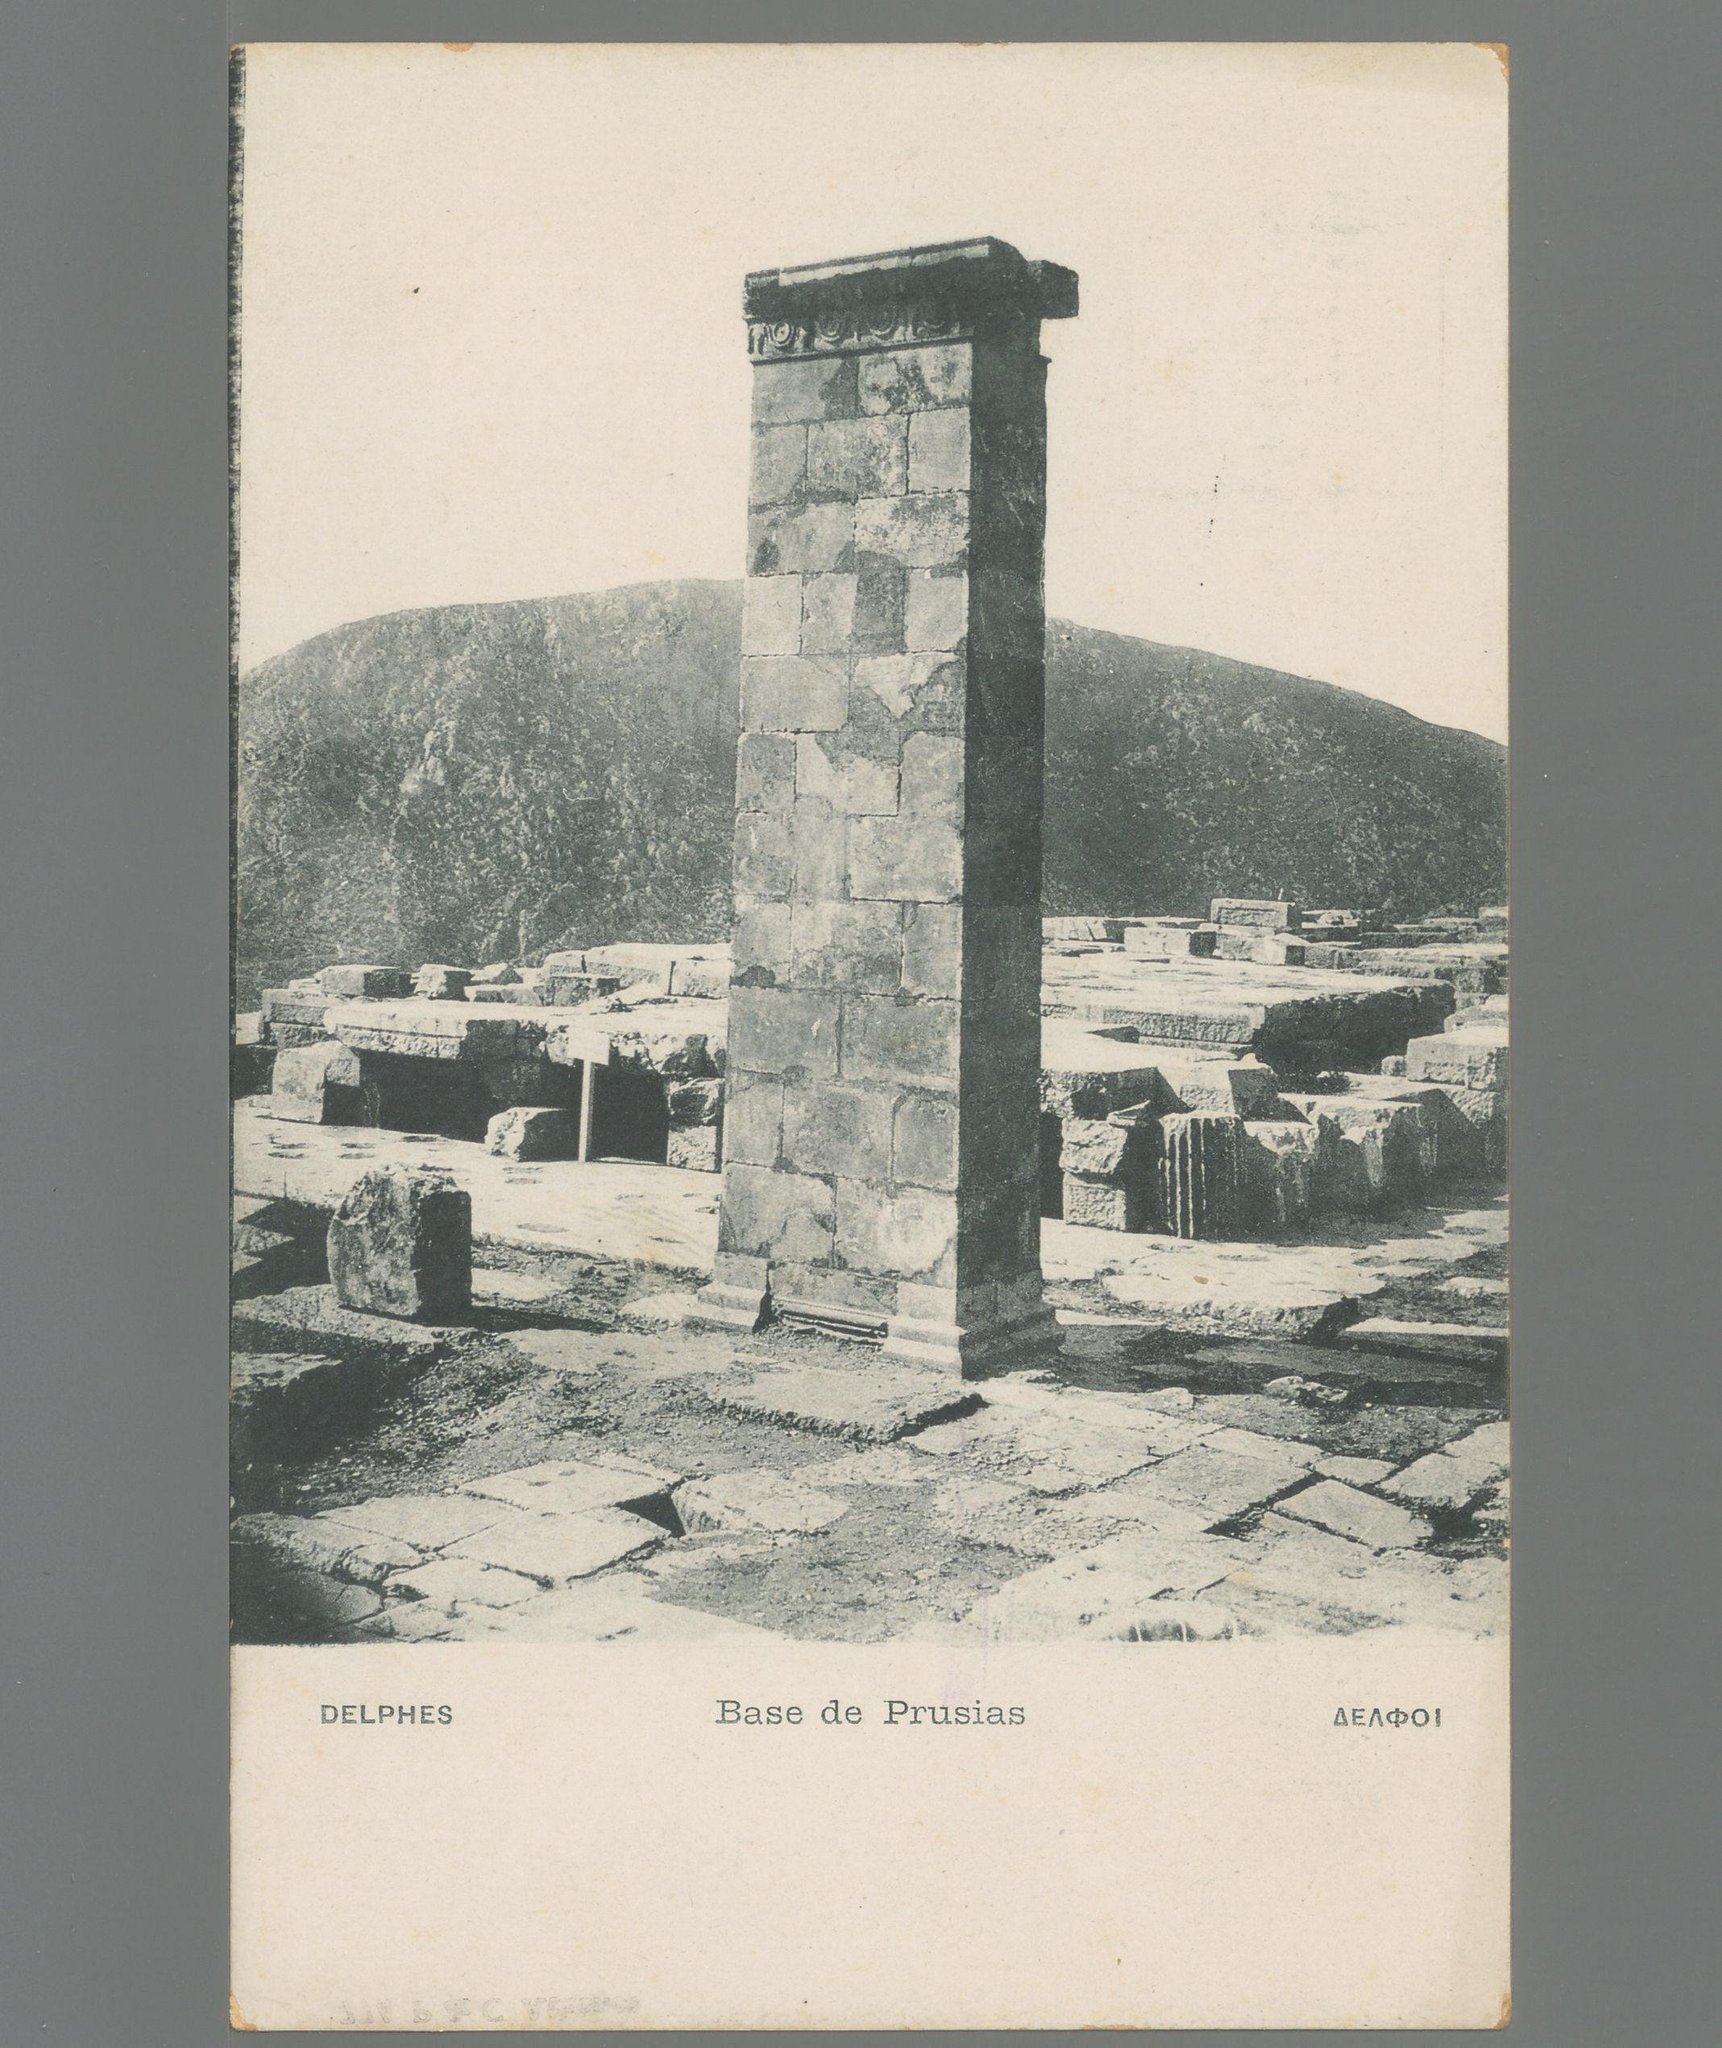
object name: ansichtkaart, prentbriefkaart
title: Delphes. Base de Prusias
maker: Anonymous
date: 1890-1906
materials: cardboard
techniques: photograph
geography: athens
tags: column, pillar ~ architecture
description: Achter de Franse titel staat de titel in het Grieks.